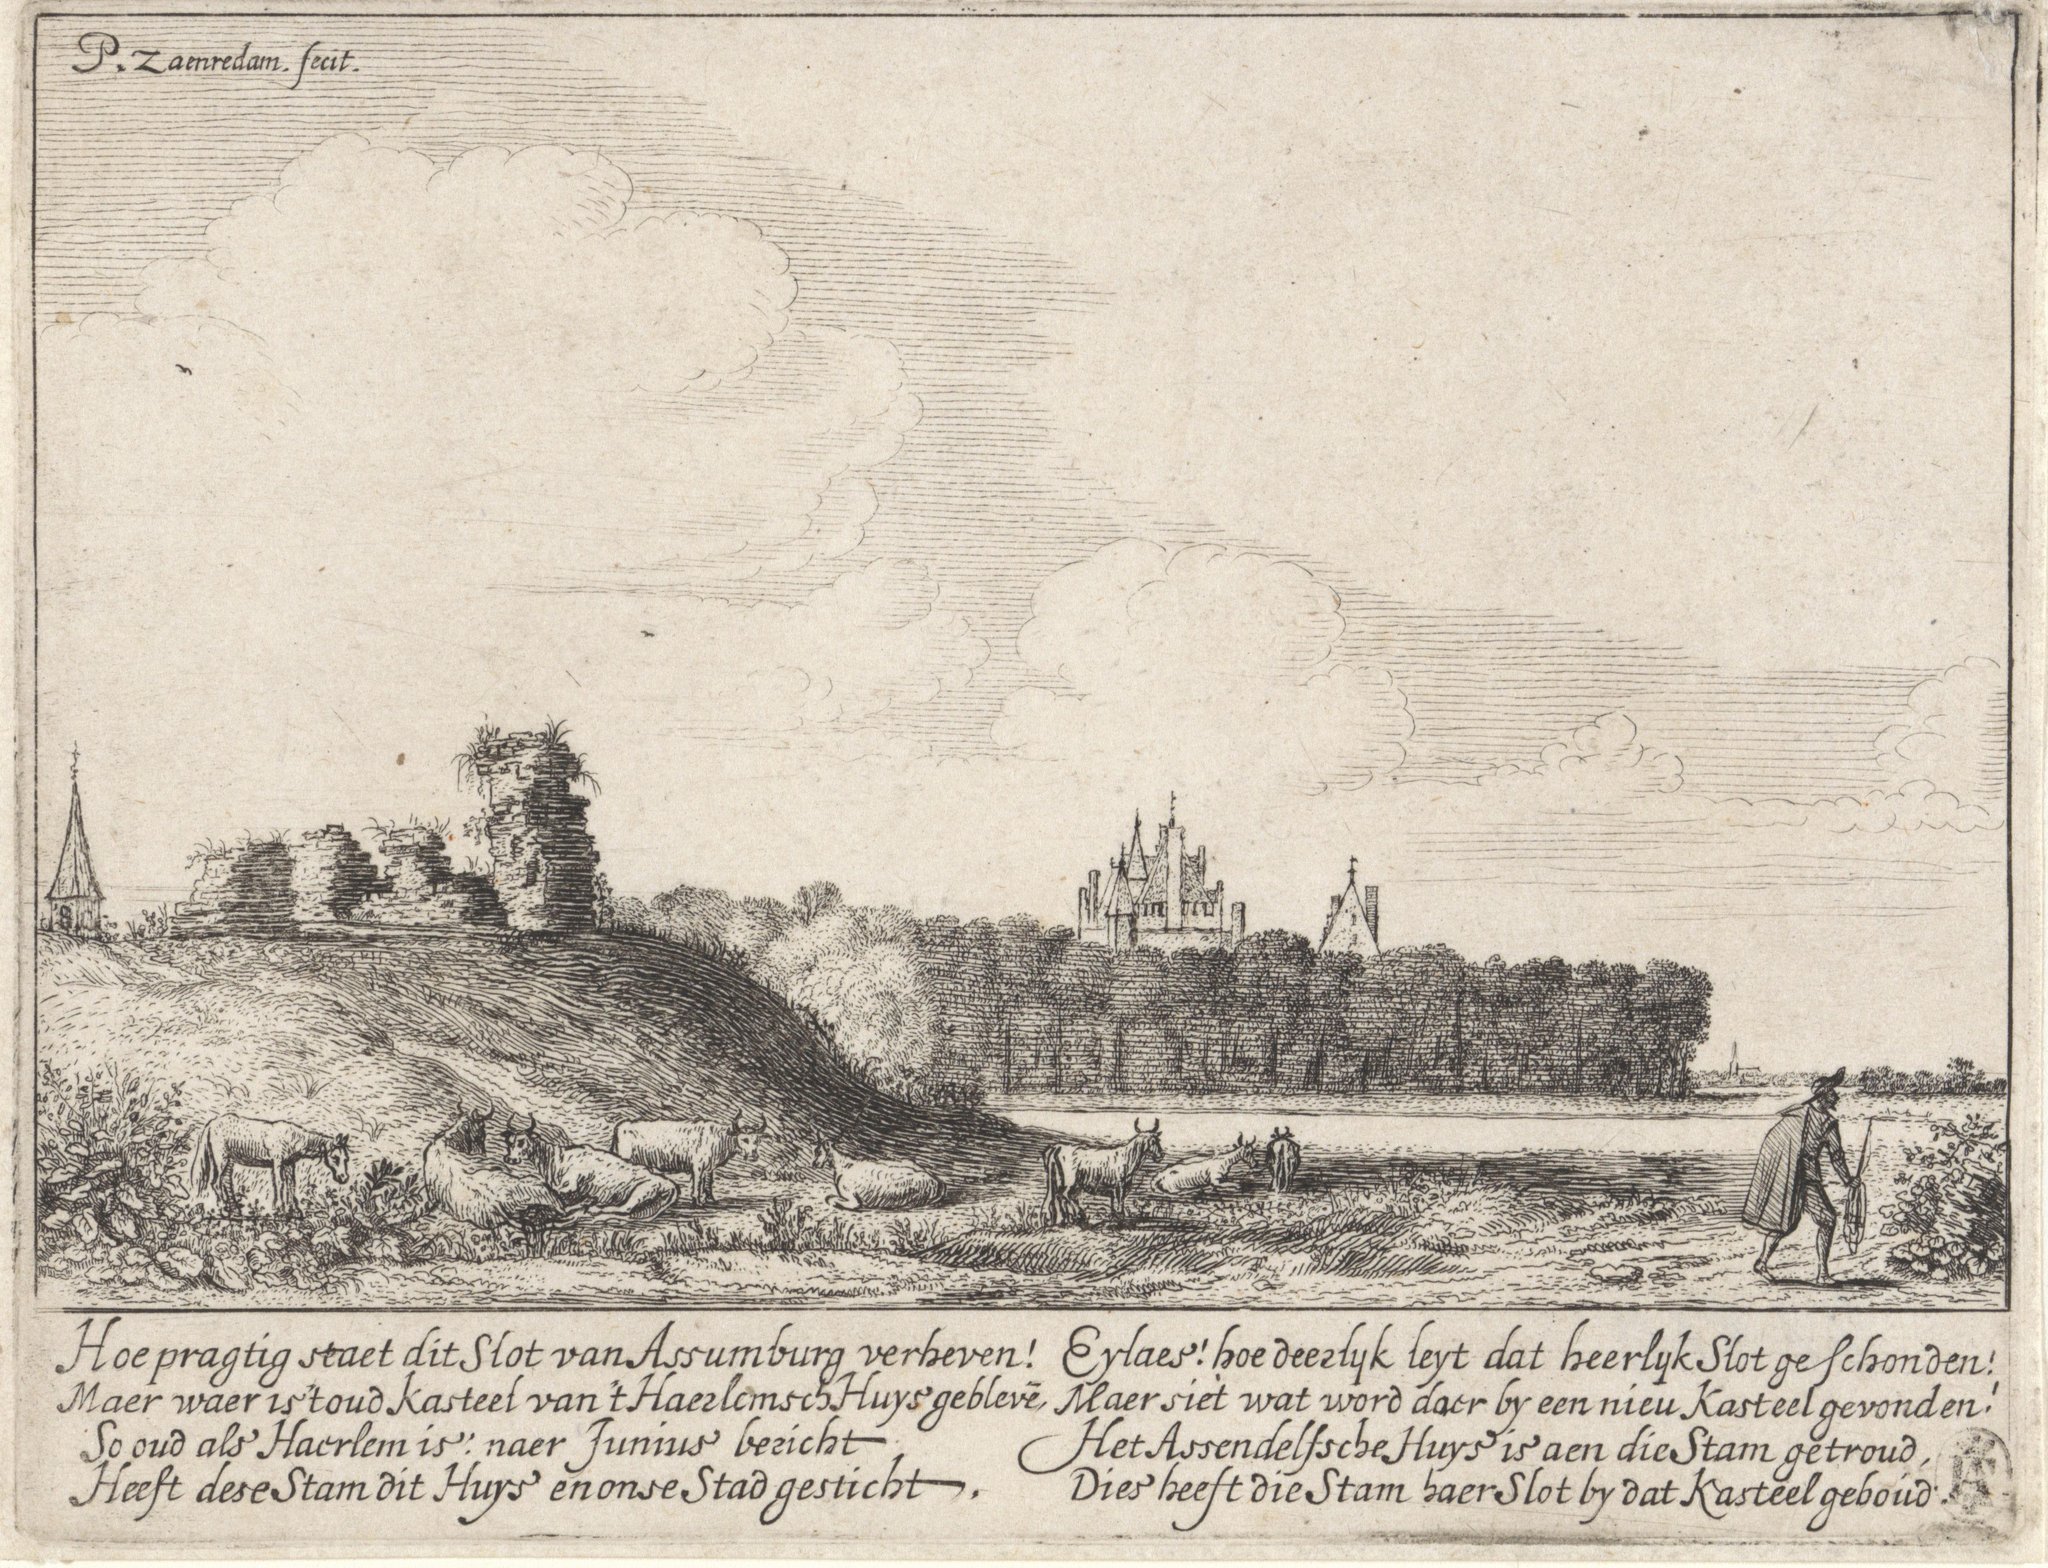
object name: print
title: Gezicht op kasteel Assumburg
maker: pieter jansz saenredam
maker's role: draughtsman, painter, print maker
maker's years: 1597-1665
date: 1628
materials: paper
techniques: etching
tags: castle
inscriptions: collector's mark: Lugt 971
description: Gezicht op kasteel Assumburg, met op de voorgrond de ruïne van kasteel Oud Haerlem en een veld met vee en een wandelaar. Het kasteel is vernoemd naar de buurtschap Assum, tussen Heemskerk en Uitgeest. In de marge een tekst over het kasteel en de ruïne.